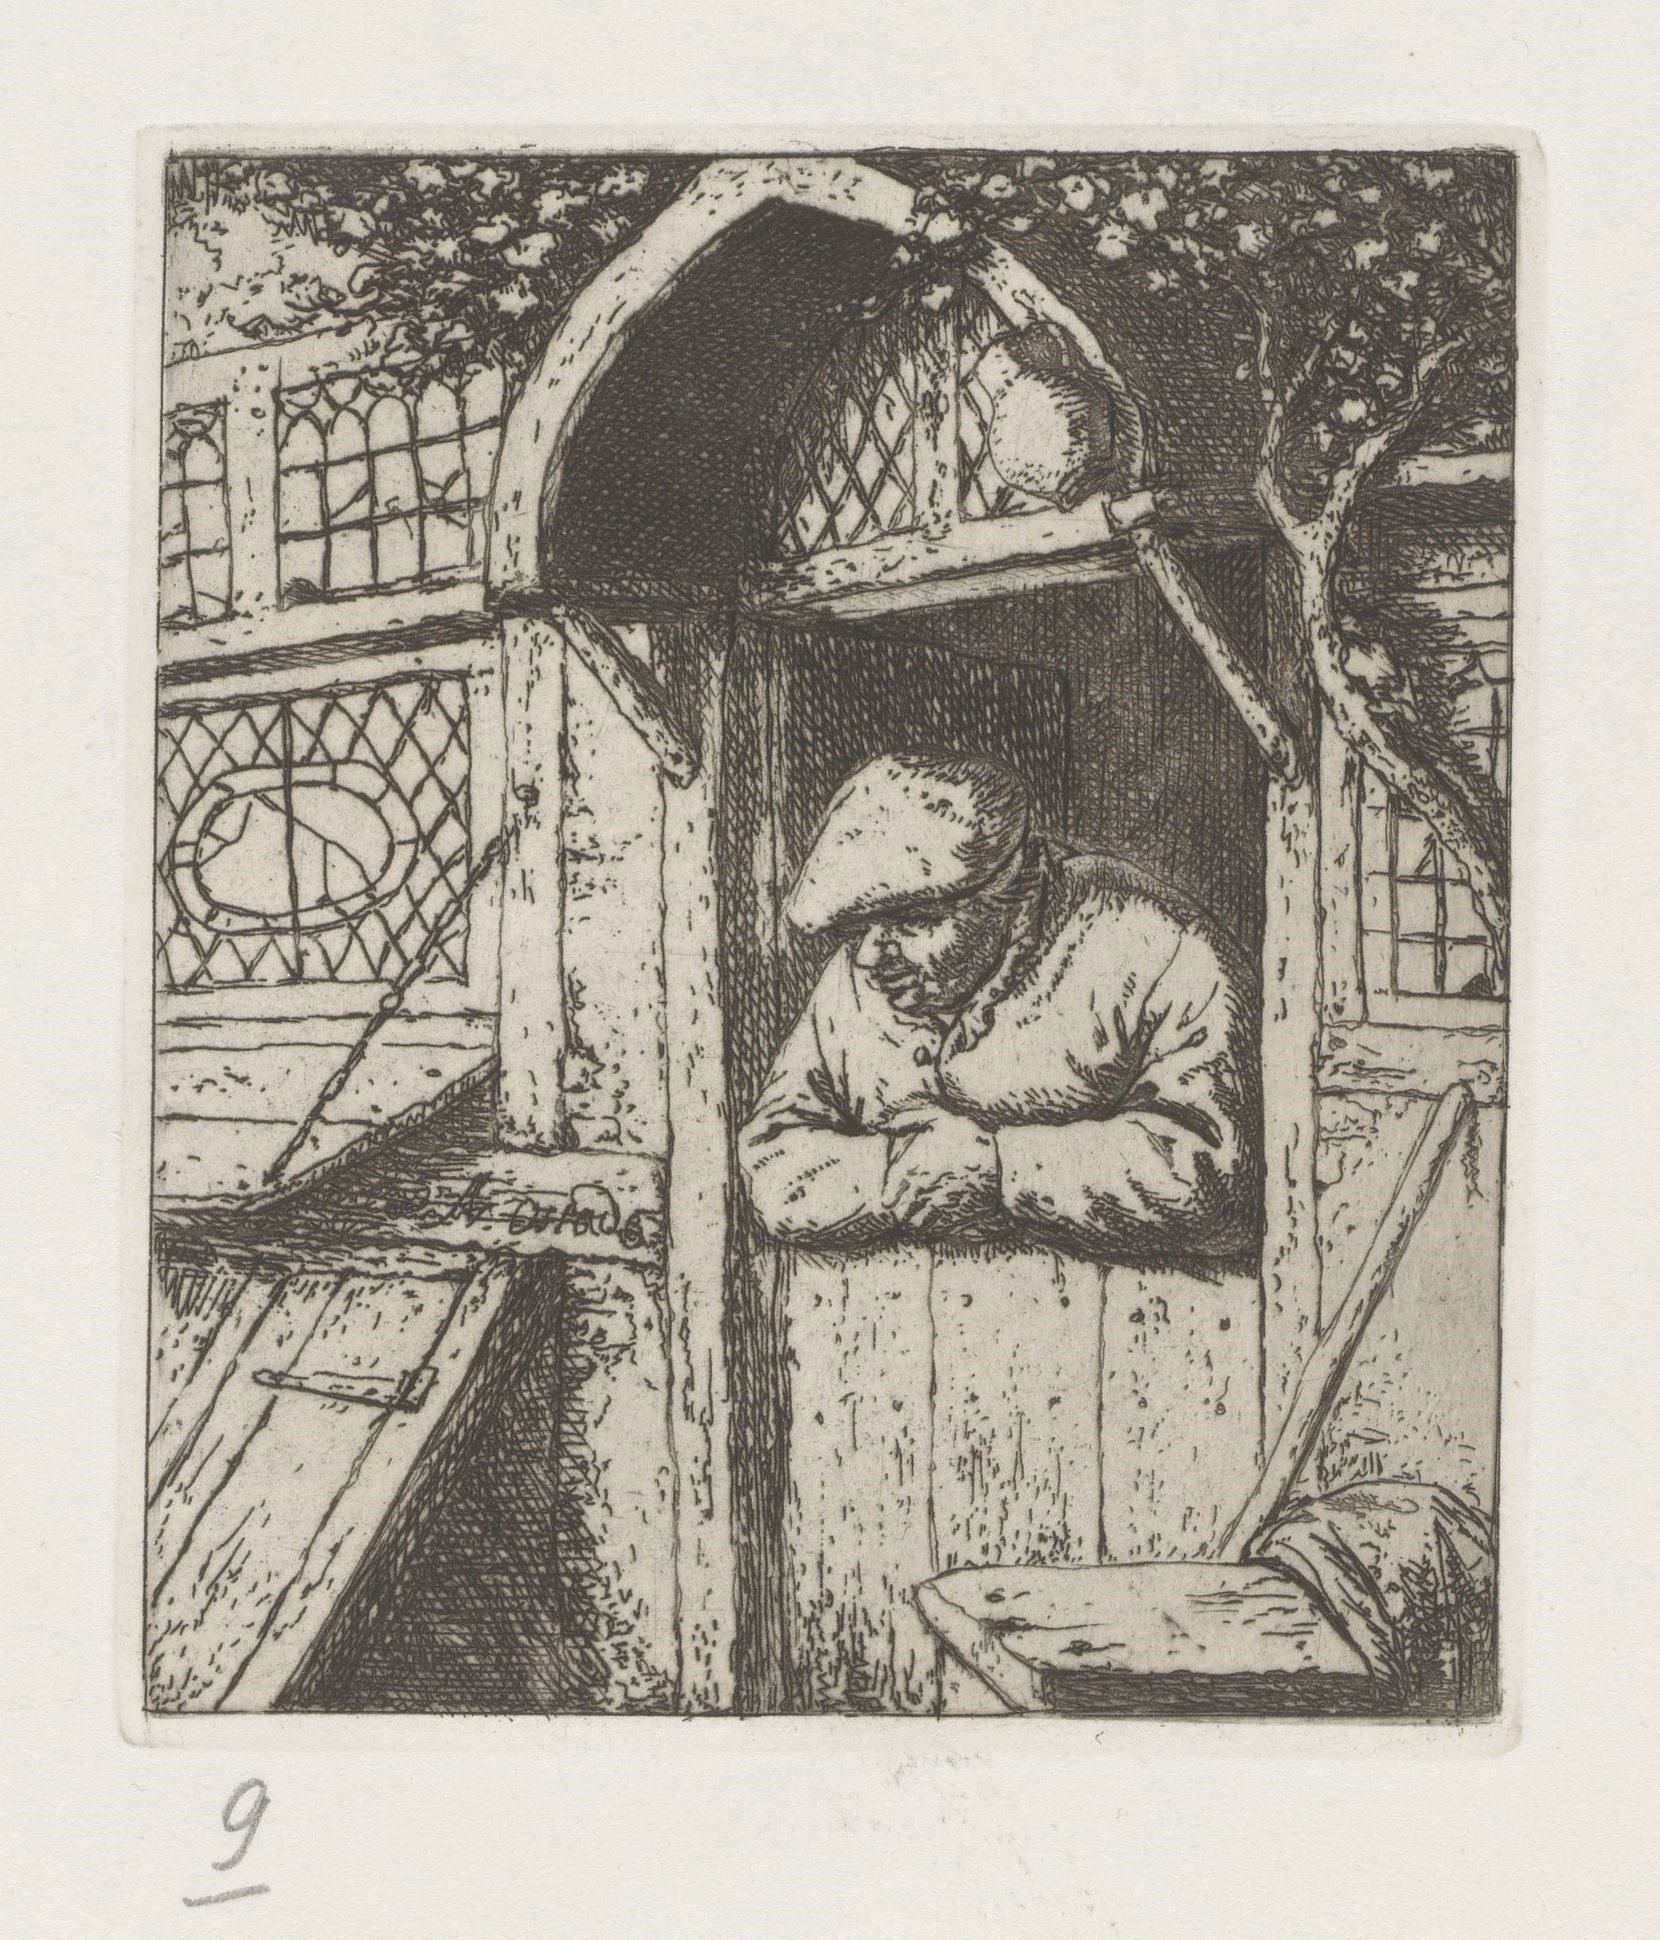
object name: print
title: Boer leunend op onderdeur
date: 1651-1655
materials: paper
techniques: etching, galvanization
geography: haarlem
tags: divided door, upper part opened, male sex; man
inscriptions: collector's mark: ‘B’, collector's mark: ‘RIJKS / MUSM’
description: De prent maakt deel uit van een portefeuille en is met een andere prent op één albumblad gedrukt.